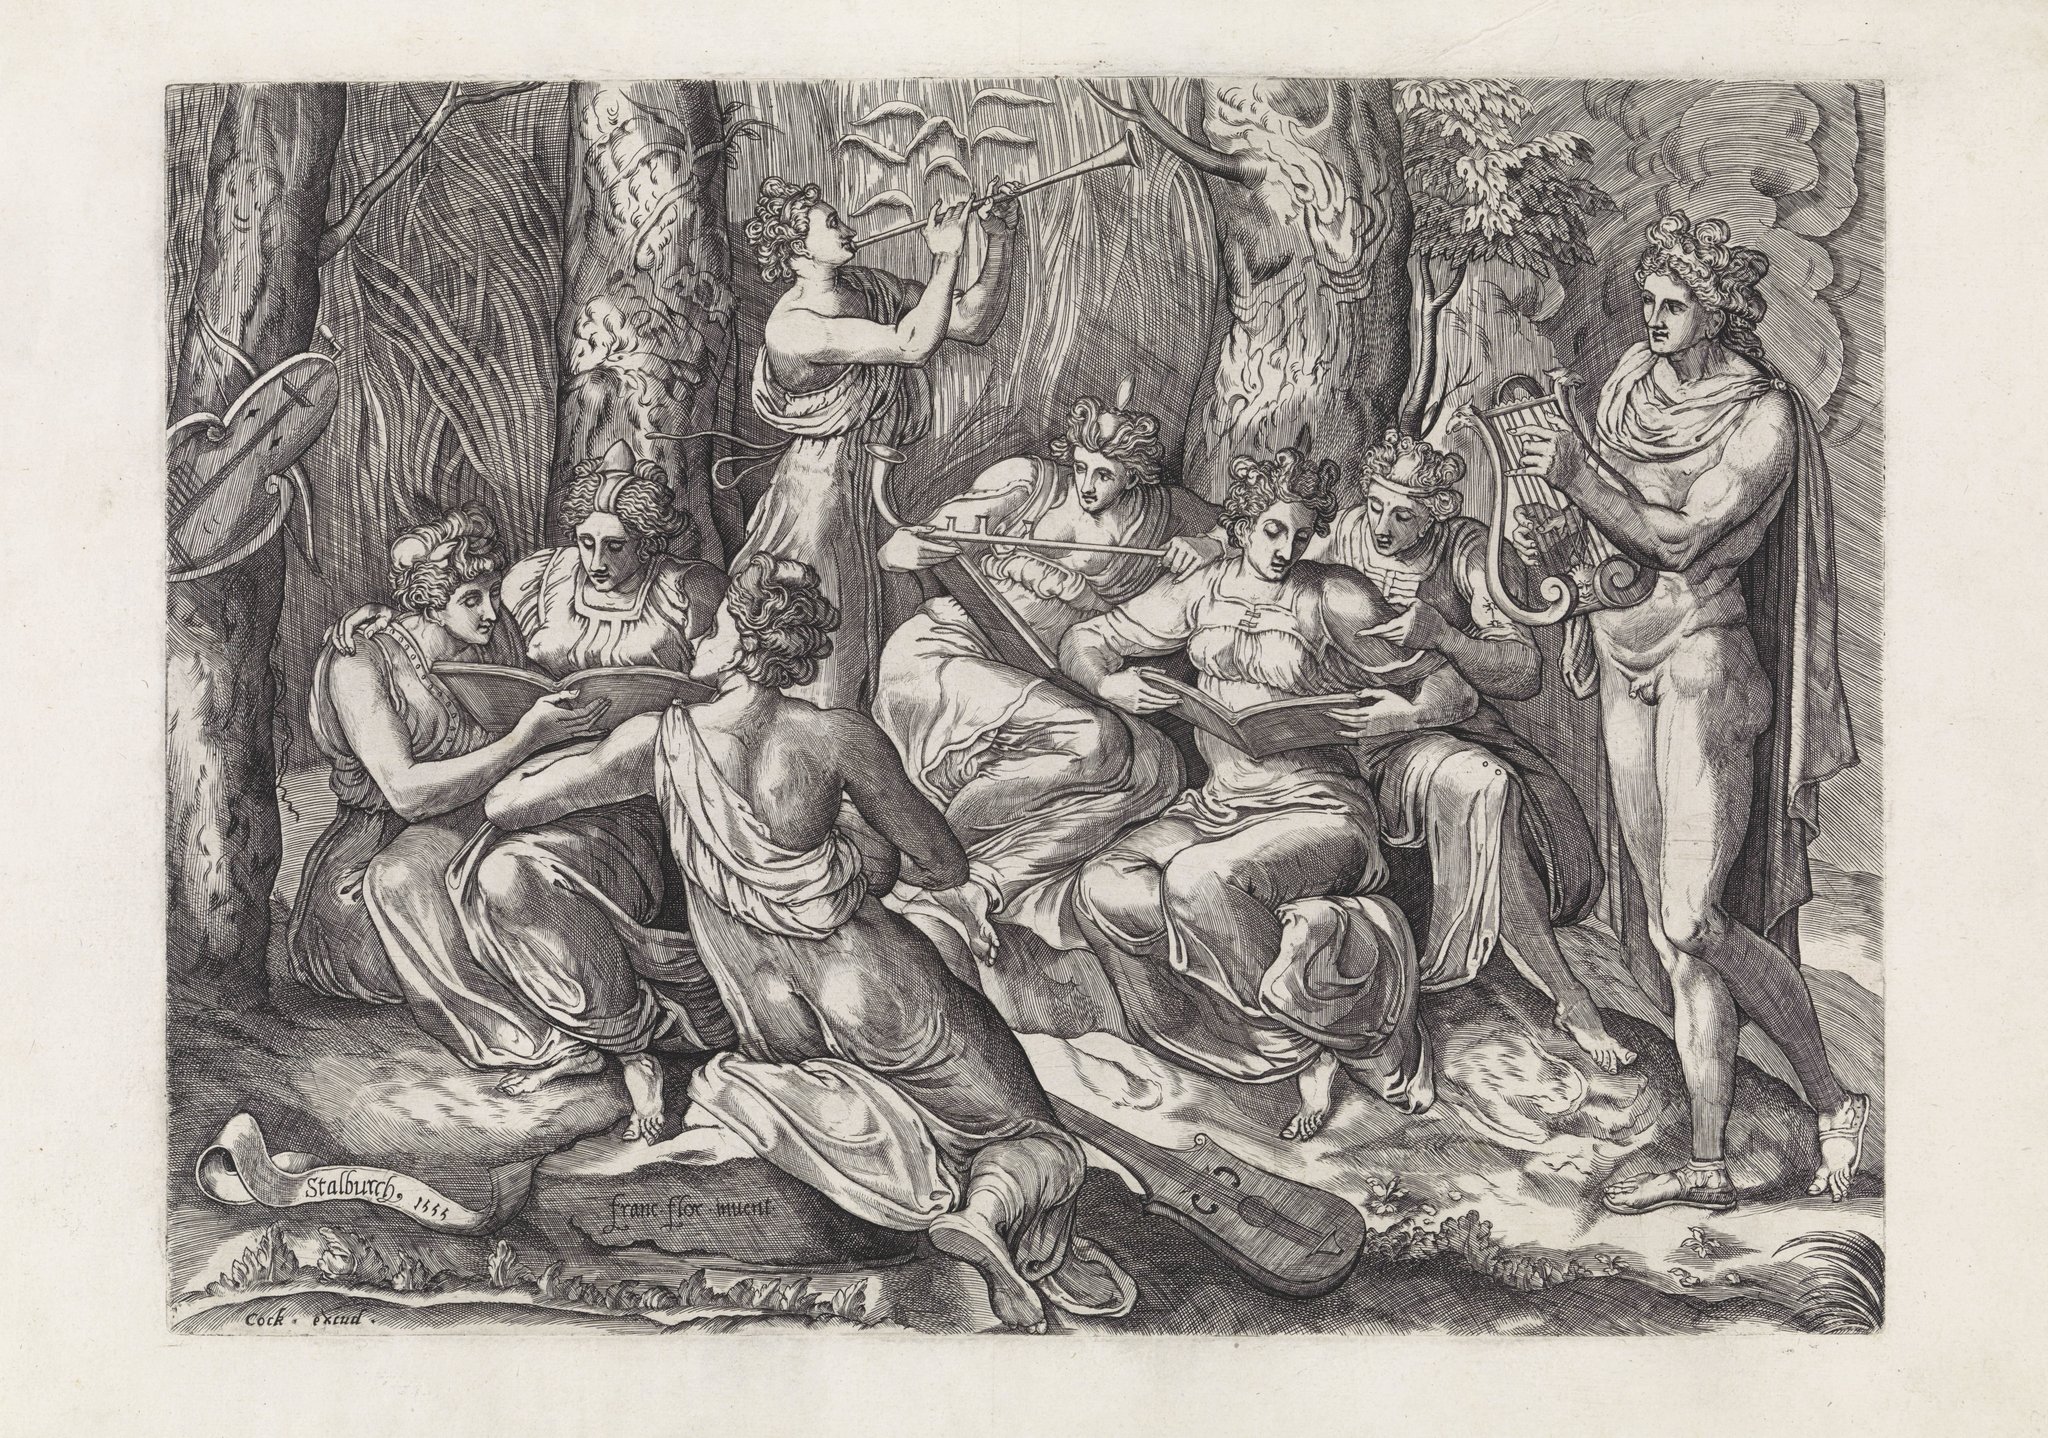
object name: print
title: Apollo en de muzen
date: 1555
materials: paper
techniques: engraving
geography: antwerp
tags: apollo and the muses, apollo musagetes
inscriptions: collector's mark: Lugt 2228, collector's mark: Lugt 2760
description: De staande Apollo bespeelt rechts de lier. Zeven muzen zitten bij elkaar en musiceren. Sommigen zingen uit een boek. Anderen houden een muziekinstrument vast of bespelen het.